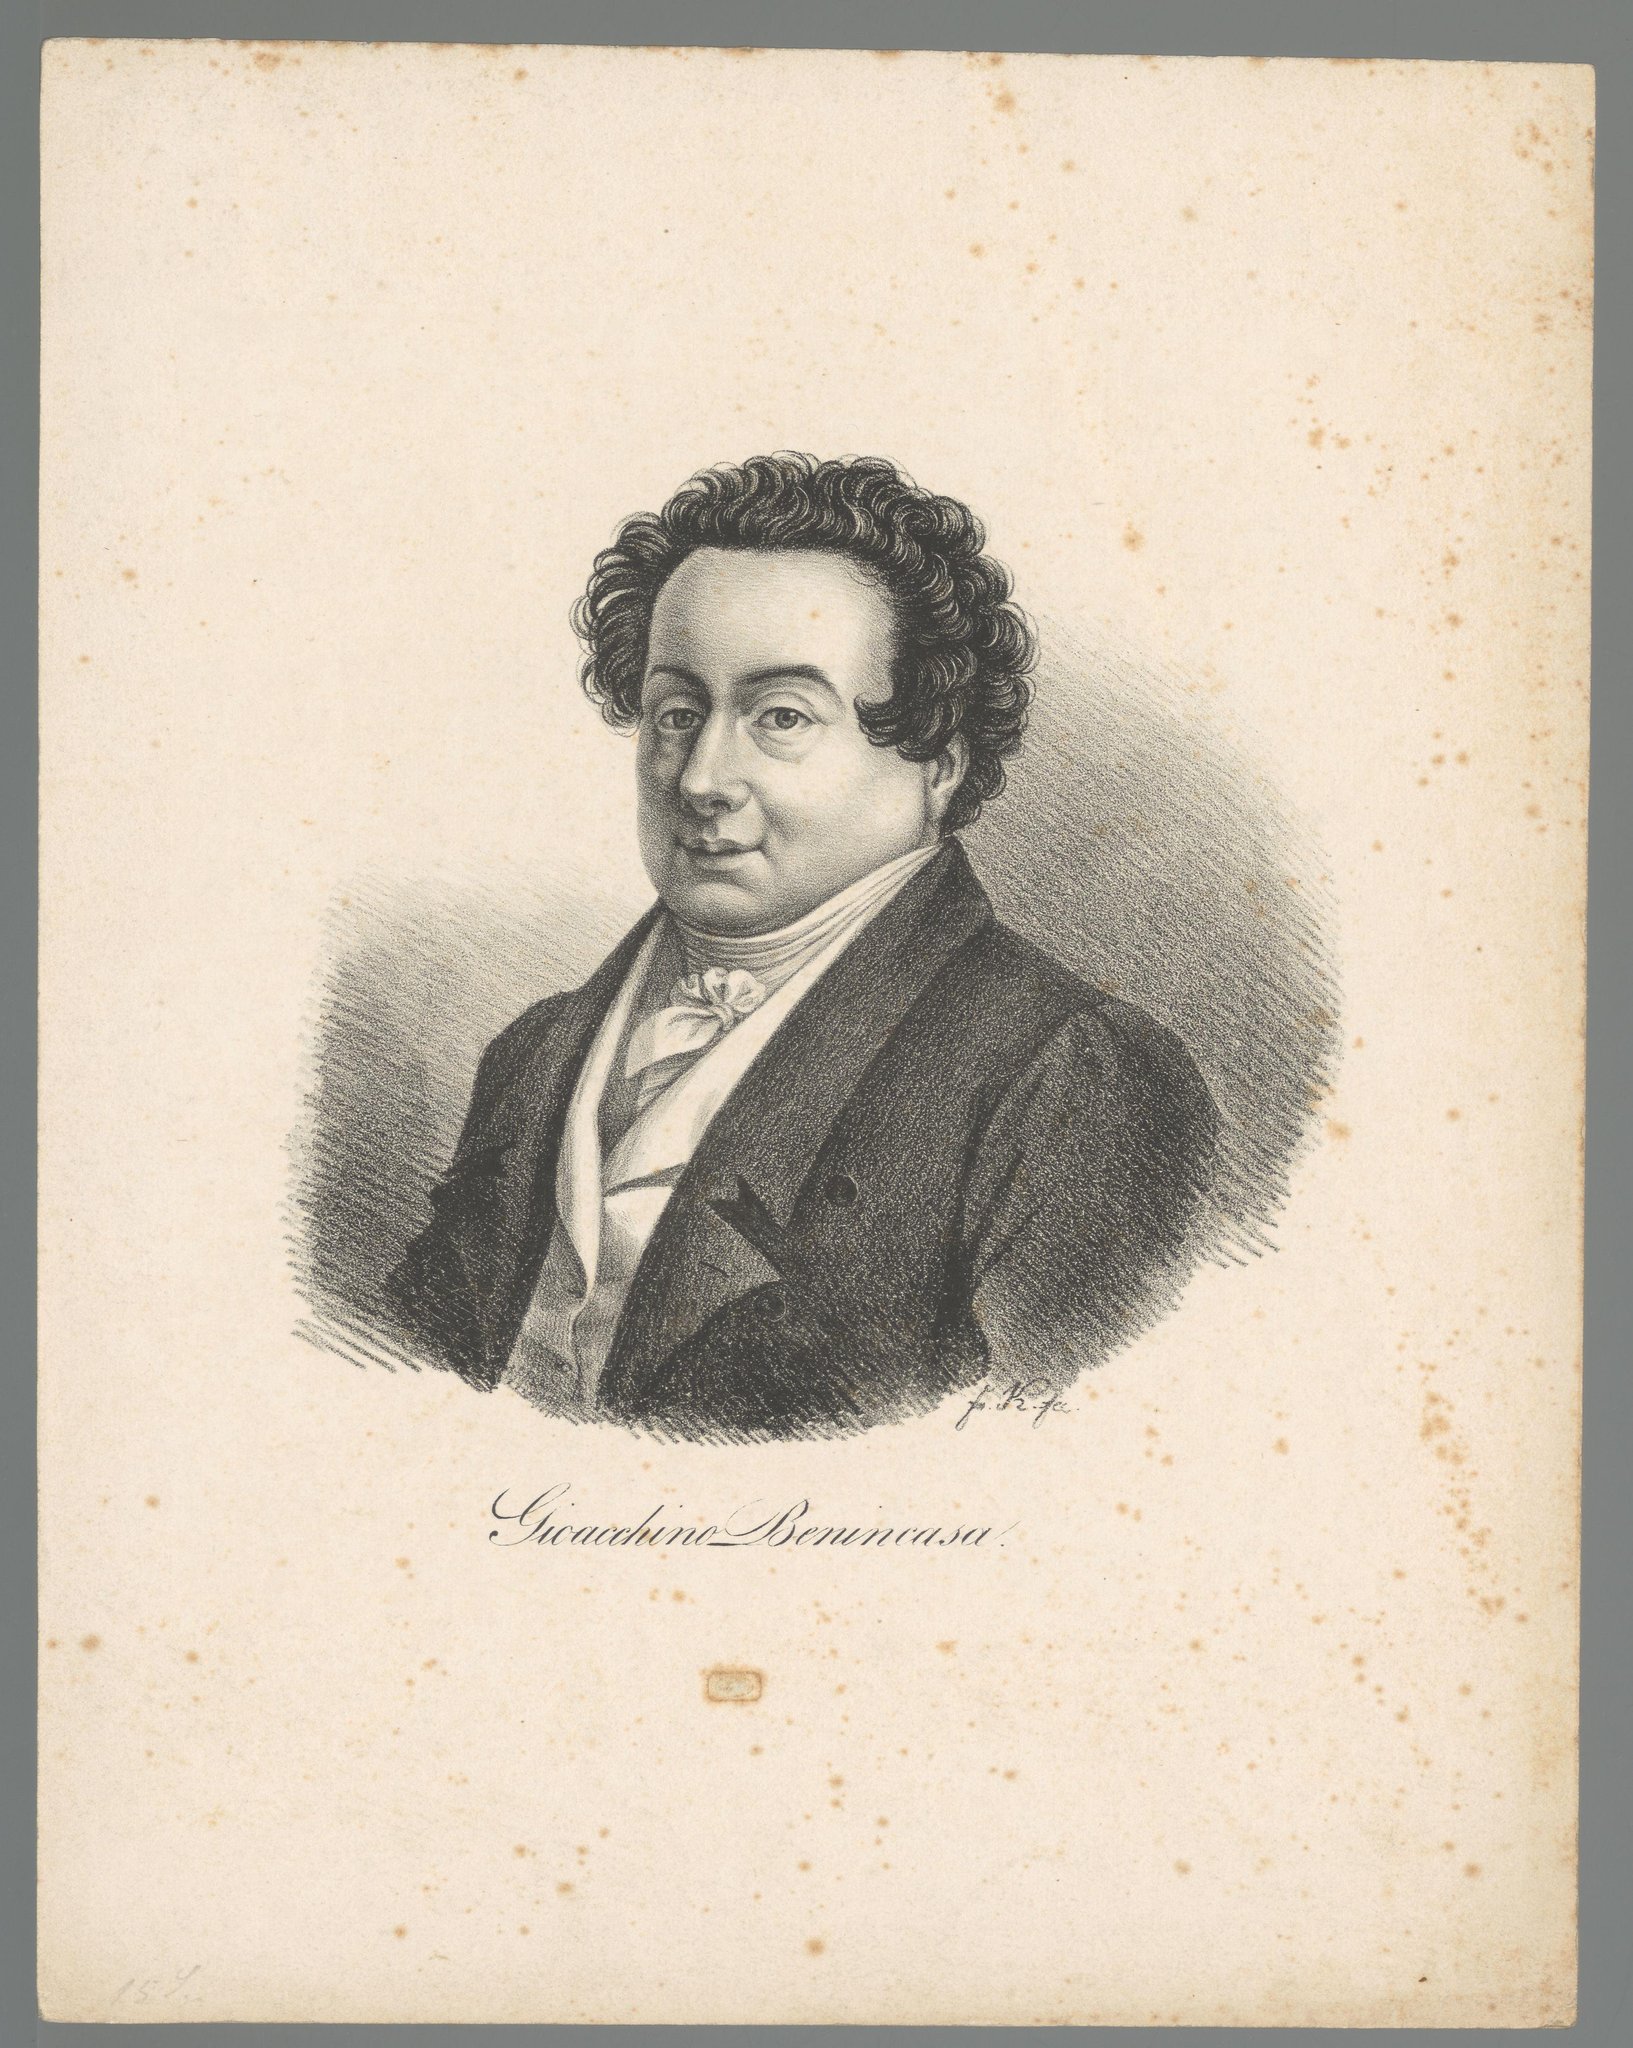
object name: print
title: Gioacchino Benincasa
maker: monogrammist fk (duitsland)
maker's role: print maker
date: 1820-1860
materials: paper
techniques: lithograph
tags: adult man, historical persons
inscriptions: collector's mark: Lugt 2228, check stamp: ‘CW&Co’